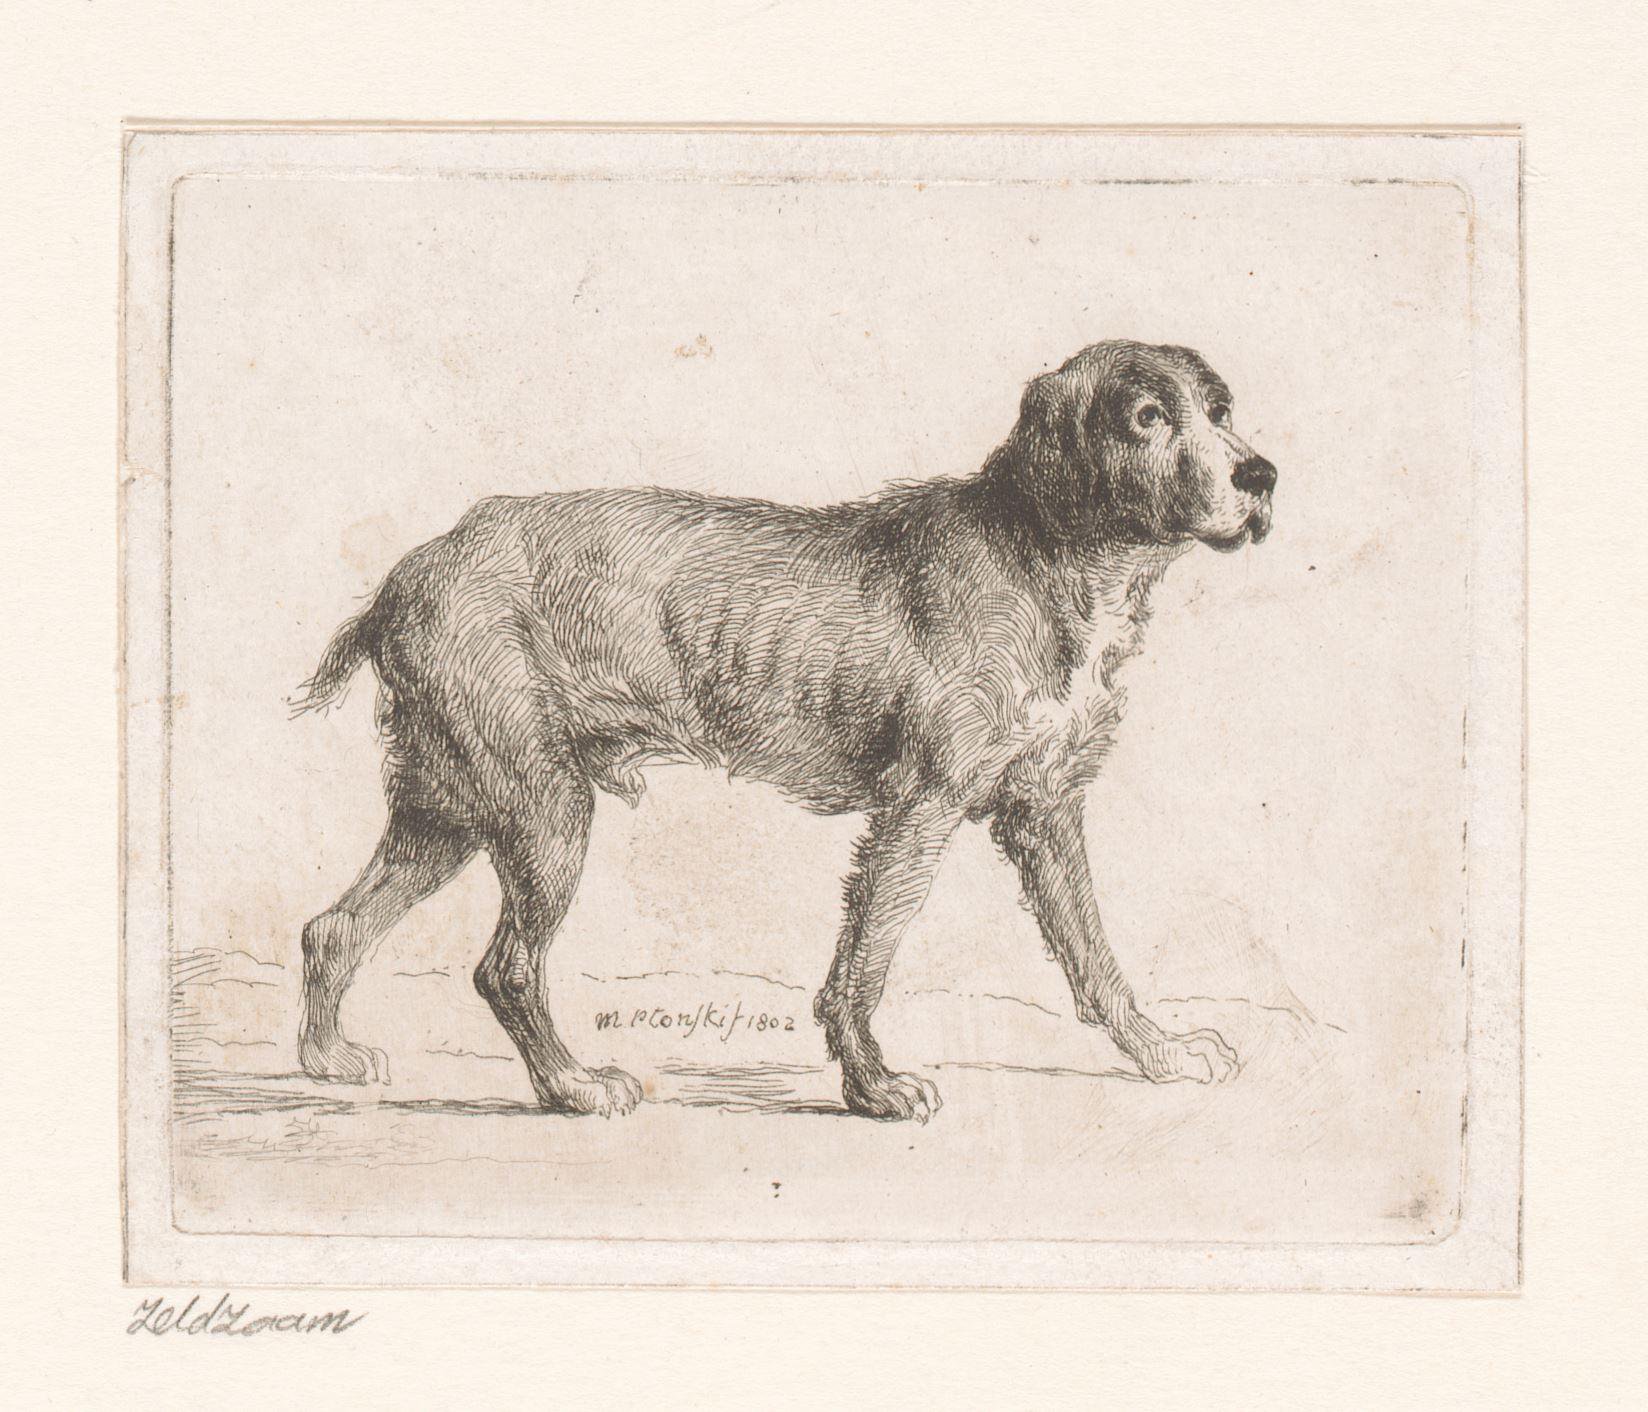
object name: print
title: Hond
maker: michał płoński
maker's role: print maker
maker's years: 1778-1812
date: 1802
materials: paper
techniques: etching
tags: dog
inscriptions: collector's mark: Lugt 2228, collector's mark: Lugt 2227